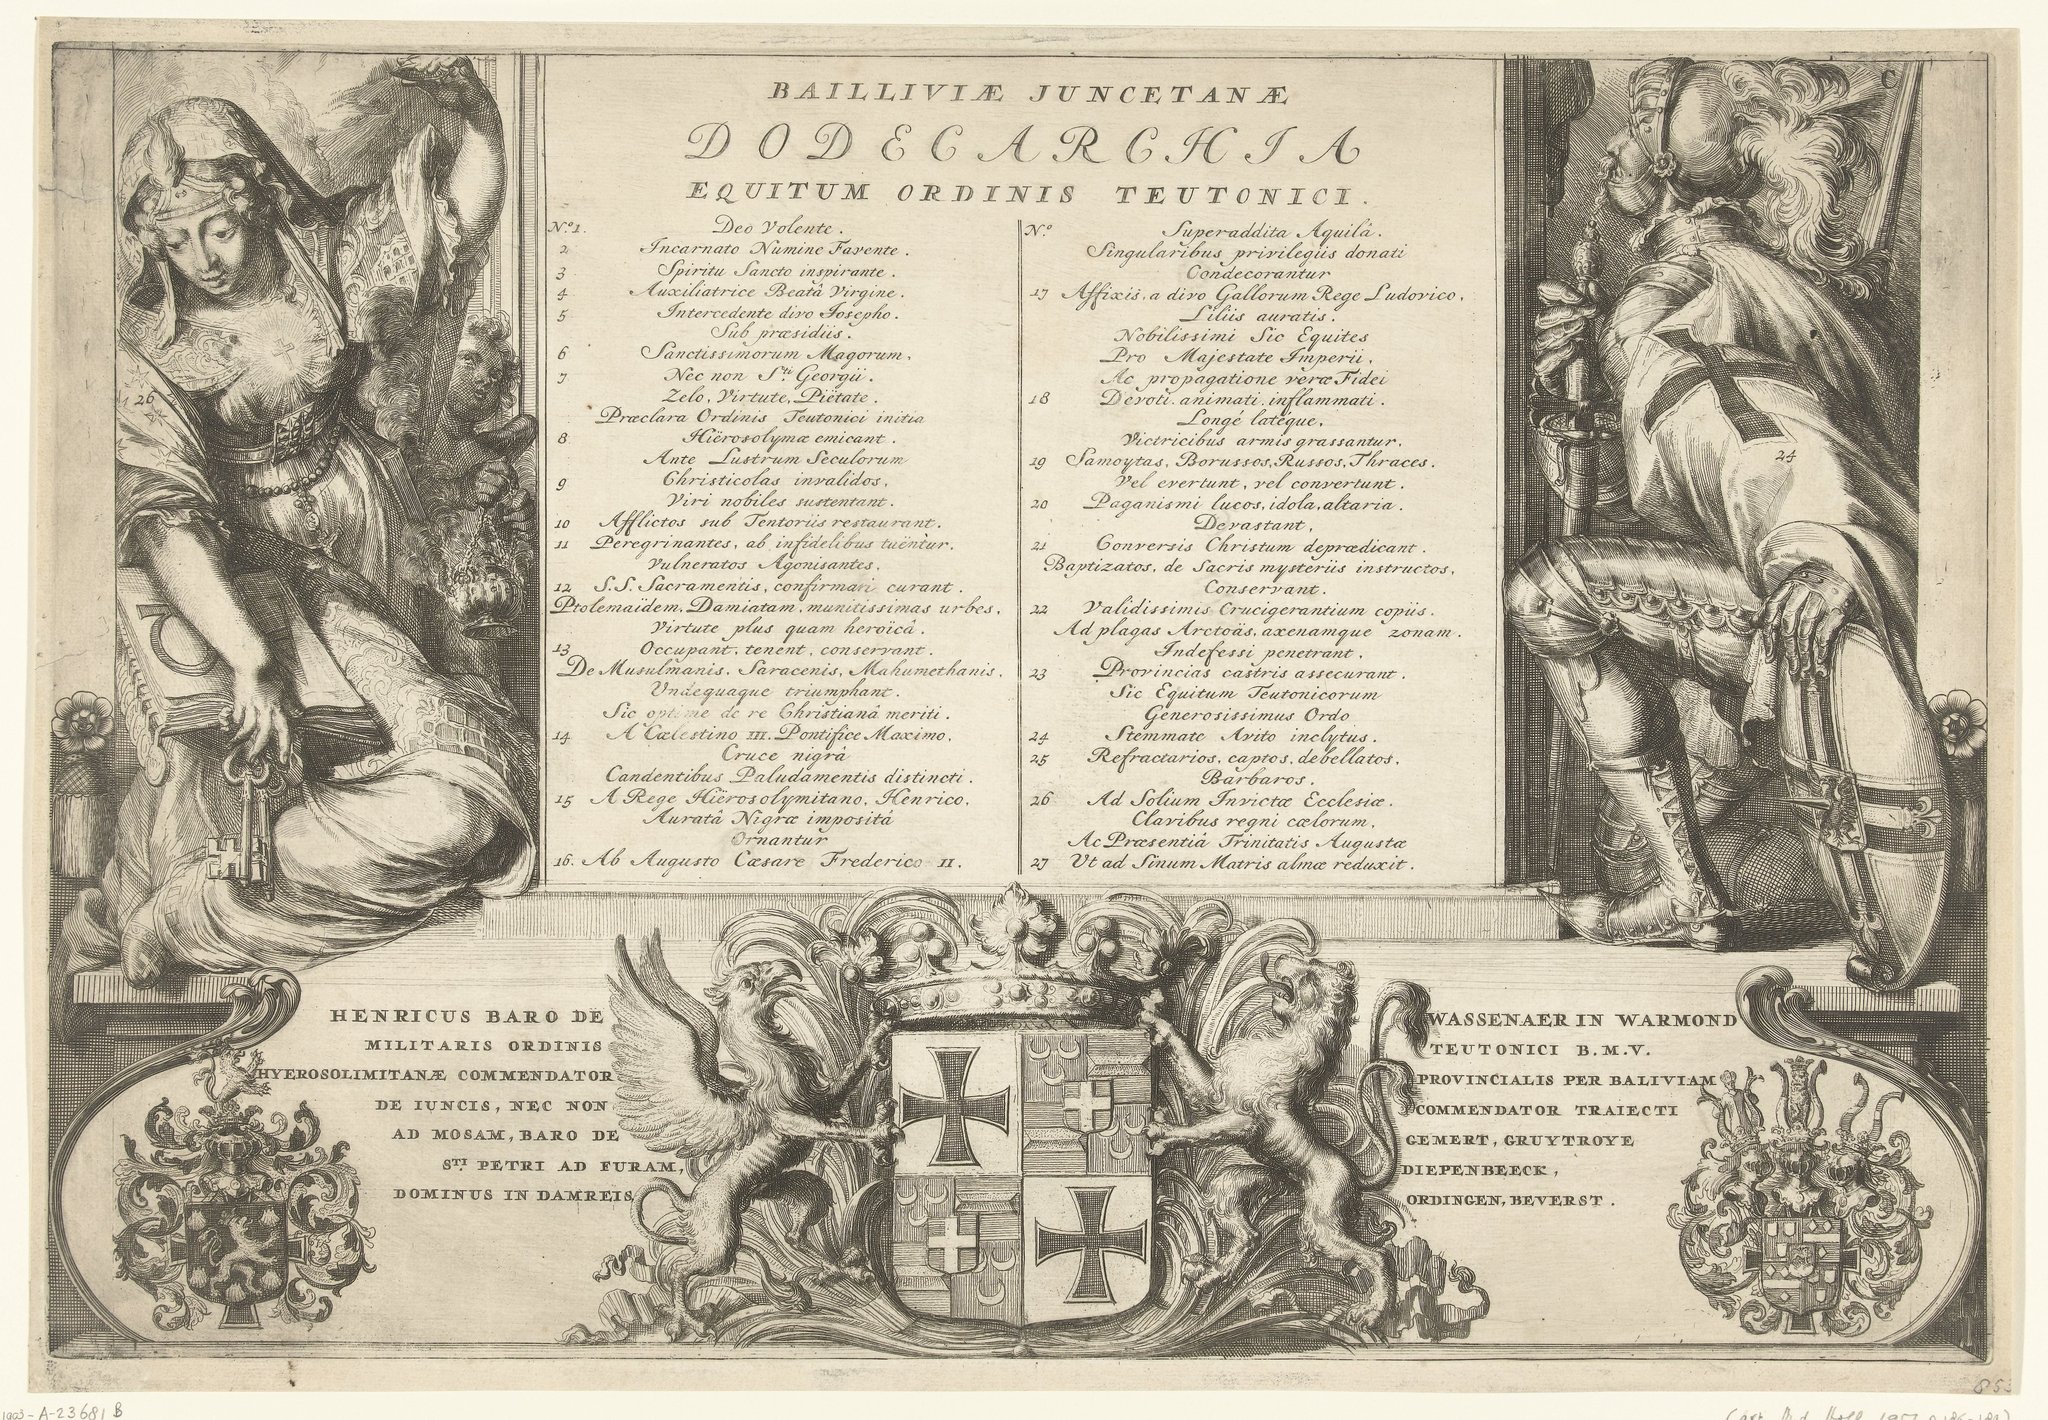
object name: print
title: Legenda bij voorstelling van geschiedenis en werken van de Duitse Orde; wapens van de landcommandeur van Alden Biesen en twee orderidders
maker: romeyn de hooghe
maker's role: draughtsman, goldsmith, painter, print maker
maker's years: 1645-1708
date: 1700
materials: paper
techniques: engraving, etching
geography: haarlem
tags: the church personified, 'ecclesia', usually with chalice and banner, the christian knight, 'miles christianus', military orders, e.g.: knights templars, knights of malta, teutonic knights ~ roman catholic church, armorial bearing, heraldry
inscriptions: collector's mark: Lugt 2228a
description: Een legenda in het Latijn bij een voorstelling van de geschiedenis en de werken van de Duitse Orde, geflankeerd door een ridder (personificatie van de Duitse Orde) en een vrouw (personificatie van de Kerk). Daaronder het wapen van de landcommandeur van Alden Biesen (Hendrik van Wassenaer), geflankeerd door dat van ruiterhoofdman/orderidder Johann Hermann baron Spies von Büllesheim, en dat van subtribuun/orderidder Damiaan Hugo, baron von Schönborn in Reichelsberg. Deze prent maakt deel uit van een omvangrijke voorstelling, samengesteld uit 20 afzonderlijke platen, van de geschiedenis en de werken van de Duitse Orde (midden) omgeven door voorstellingen van de landcommanderij Alden Biesen (onderaan) en de daarbij behorende commanderijen (links en rechts).